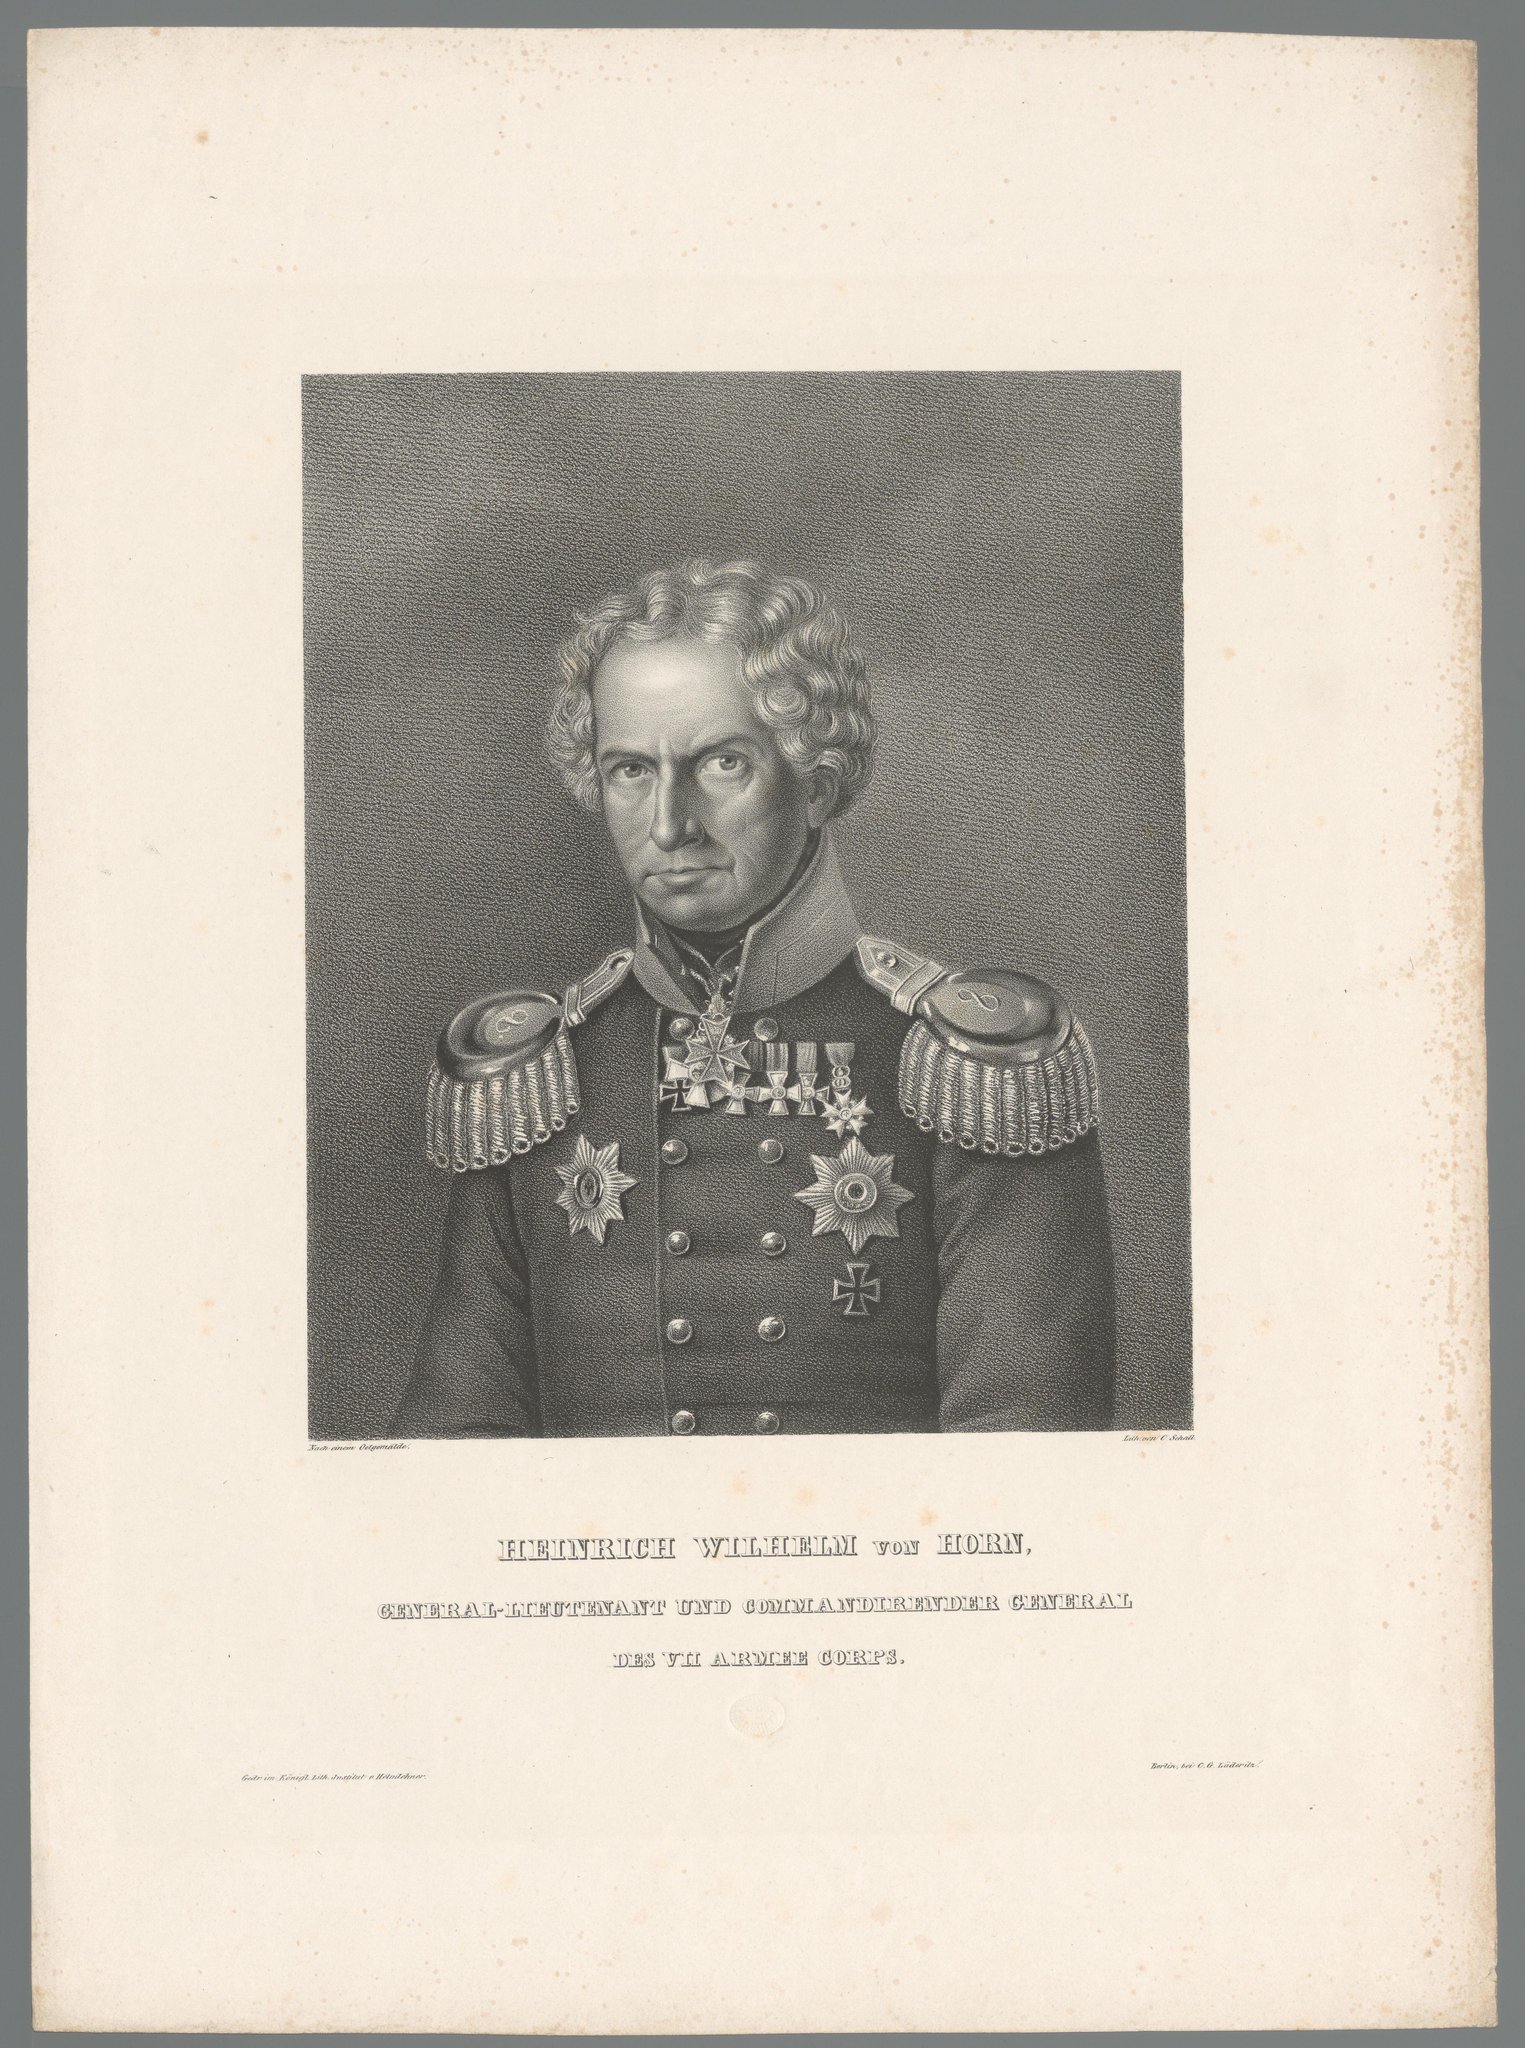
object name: print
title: Heinrich Wilhelm von Horn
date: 1820-1865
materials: paper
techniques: lithograph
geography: berlin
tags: adult man, historical persons, (military) uniforms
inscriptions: collector's mark: Lugt 2228, check stamp: Lugt 4519